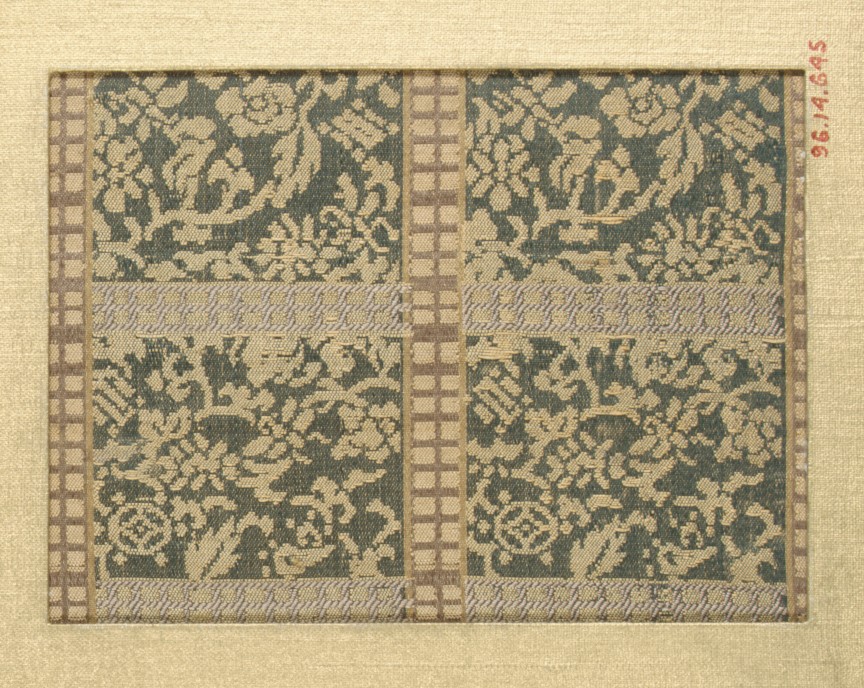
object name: piece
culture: japanese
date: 1701-1900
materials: silk